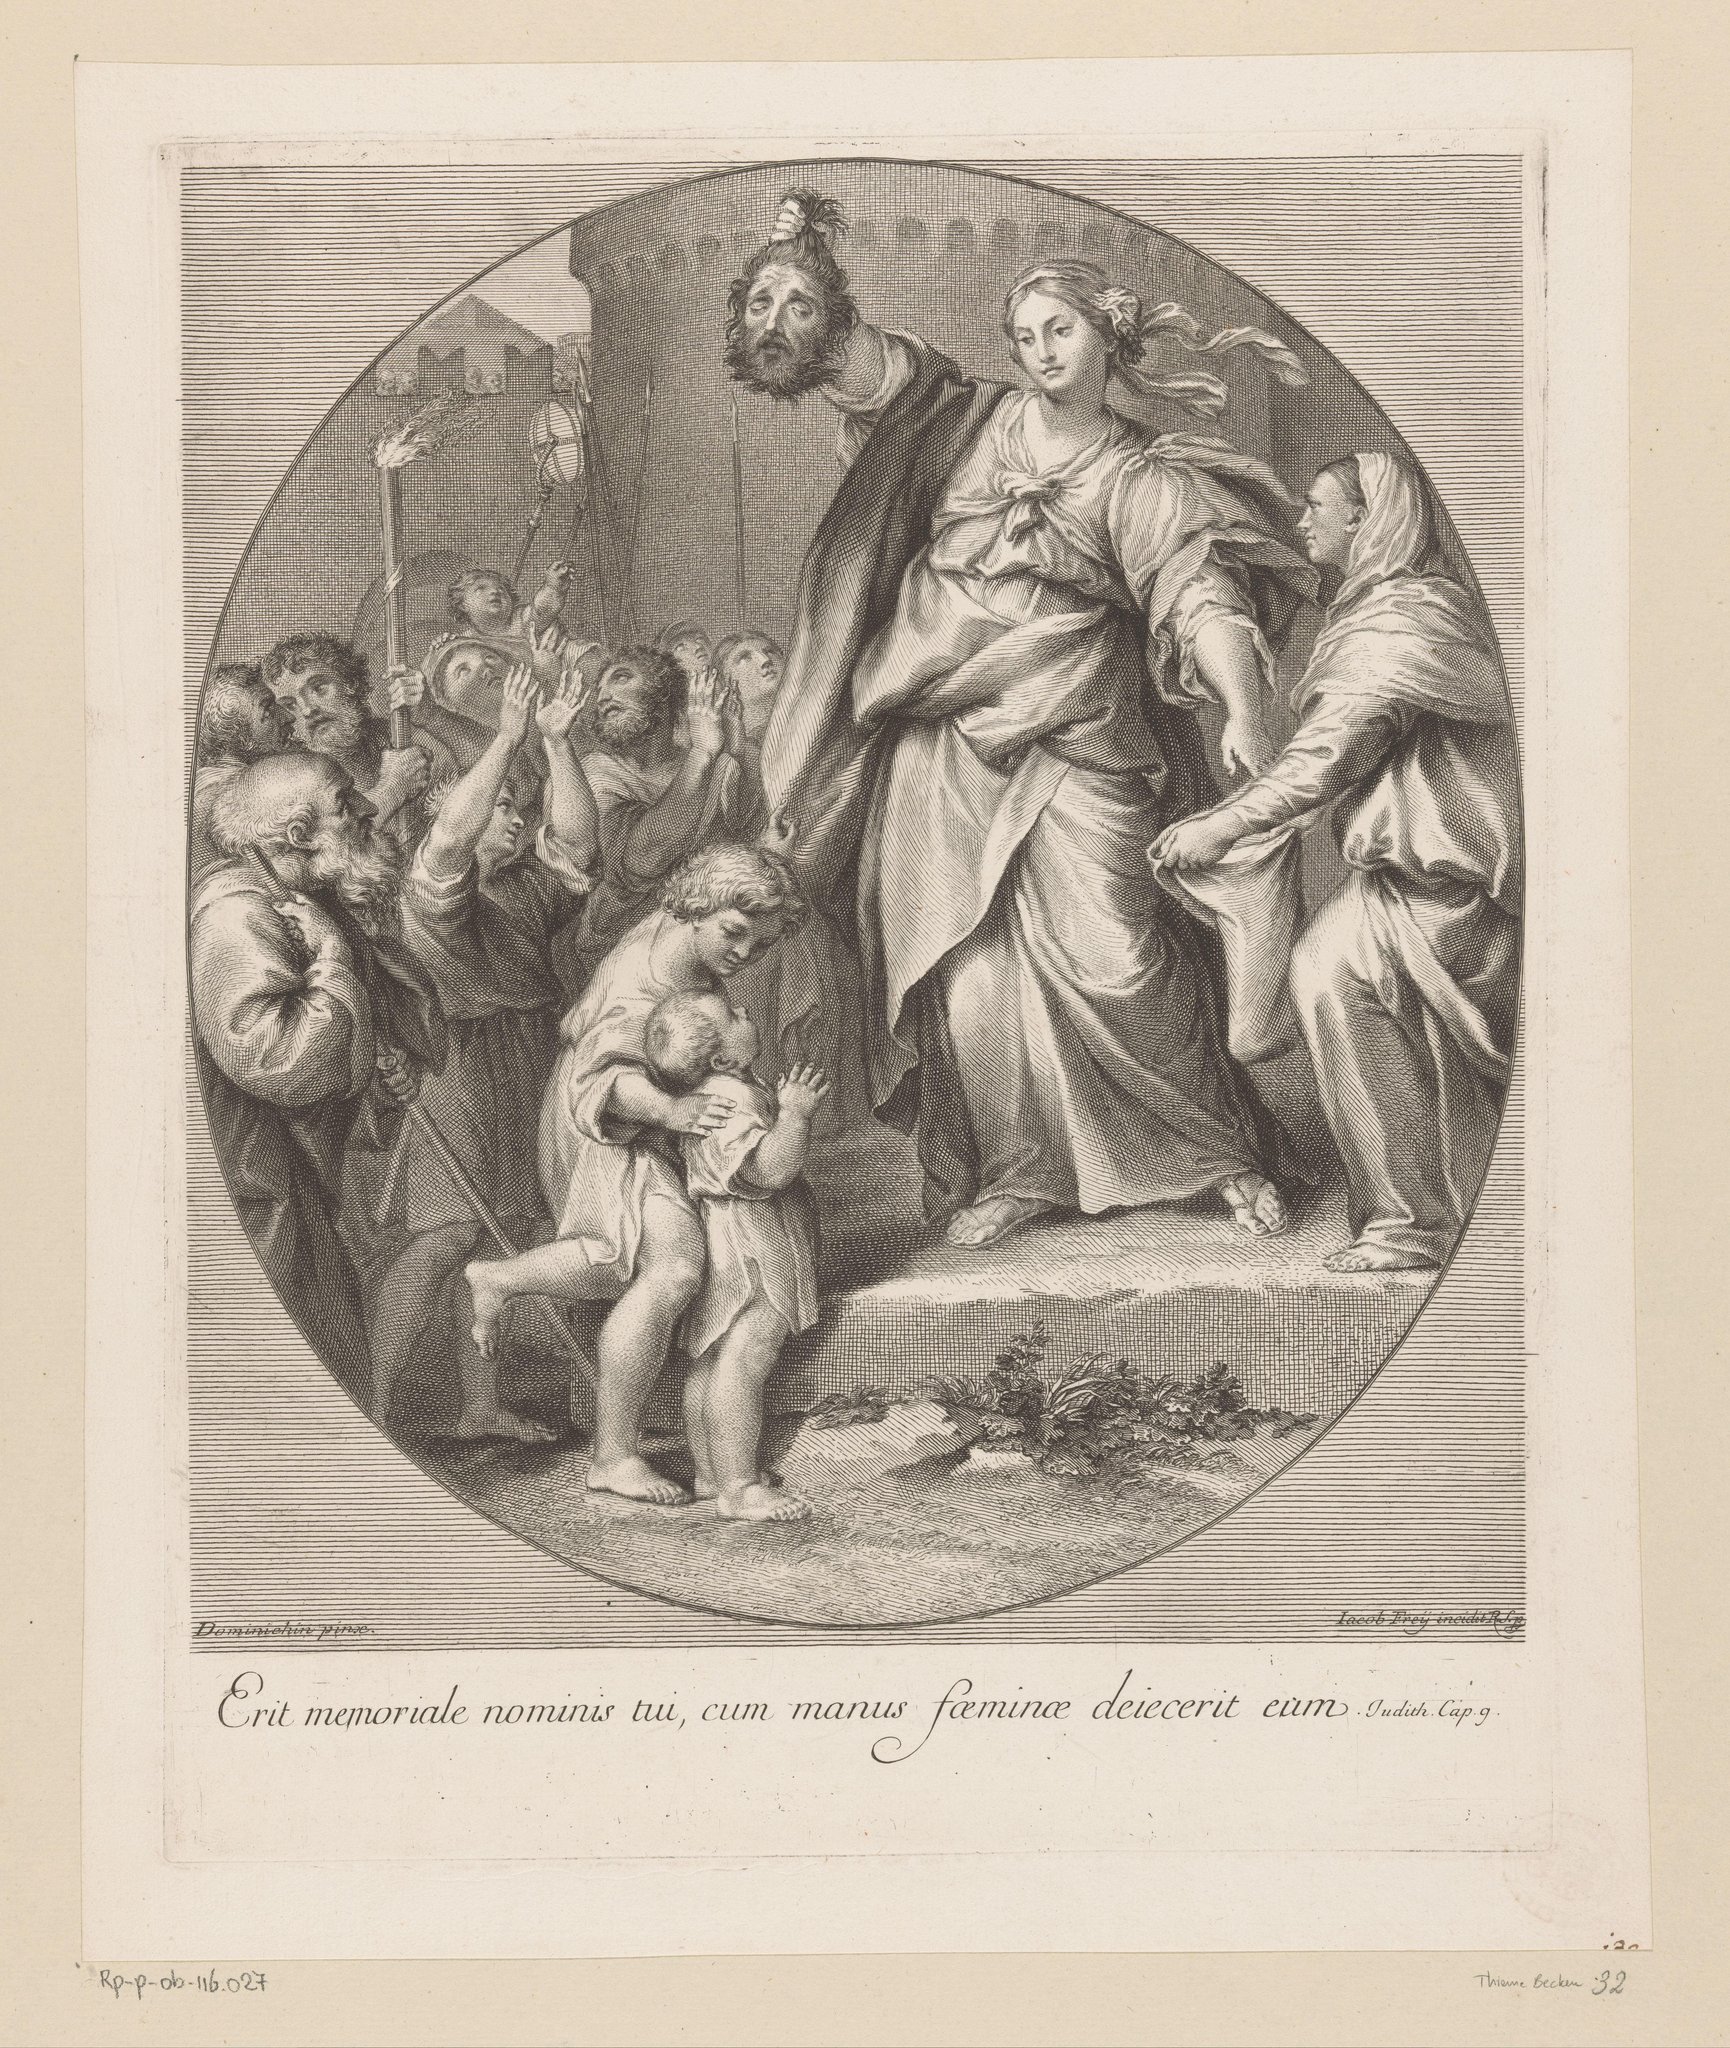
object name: print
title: Judith toont het hoofd van Holofernes aan het volk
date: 1718-1719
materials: paper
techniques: engraving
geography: rome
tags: judith shows holofernes' head to the people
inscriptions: collector's mark: Lugt 240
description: Naar één van de vier tondo's door Domenichino in de San Silvestro al Quirinale in Rome.